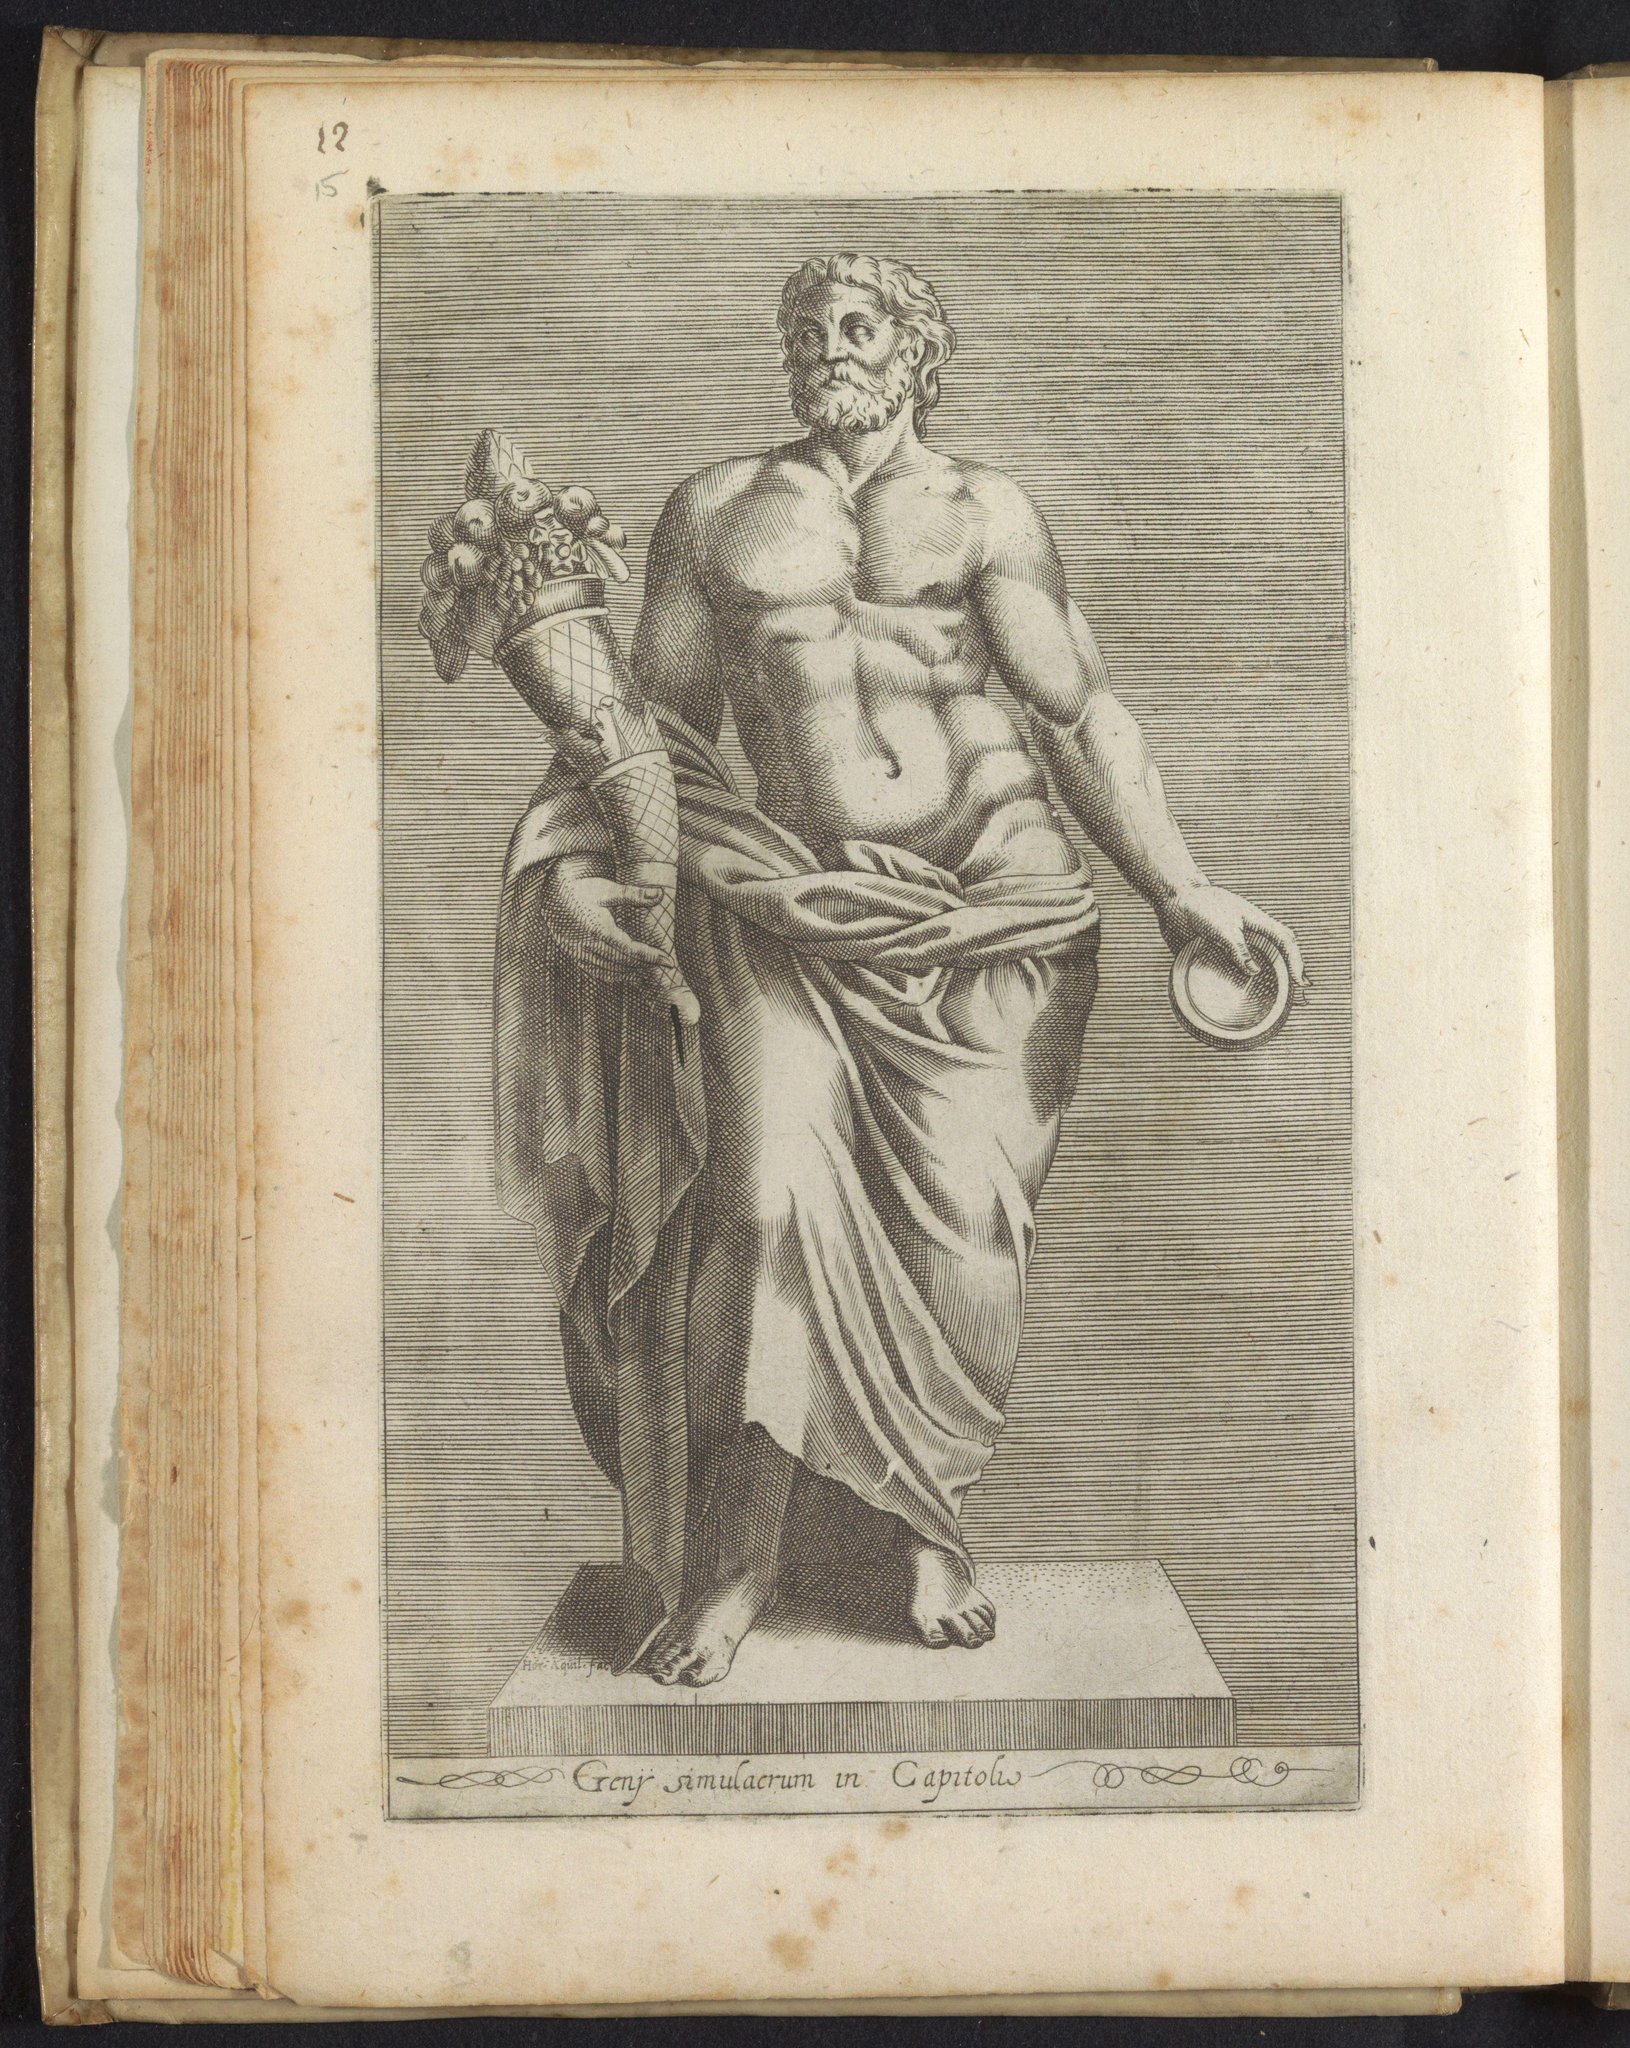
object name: print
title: Antieke sculpturen in Rome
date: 1584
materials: paper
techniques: engraving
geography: italy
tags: piece of sculpture, reproduction of a piece of sculpture, man (showing himself) undressed, quasi-nude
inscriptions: number: ‘12’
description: Deze prent maakt deel uit van een set van 79 prenten (+ titelprent) met voorstellingen van antieke sculpturen in Rome.